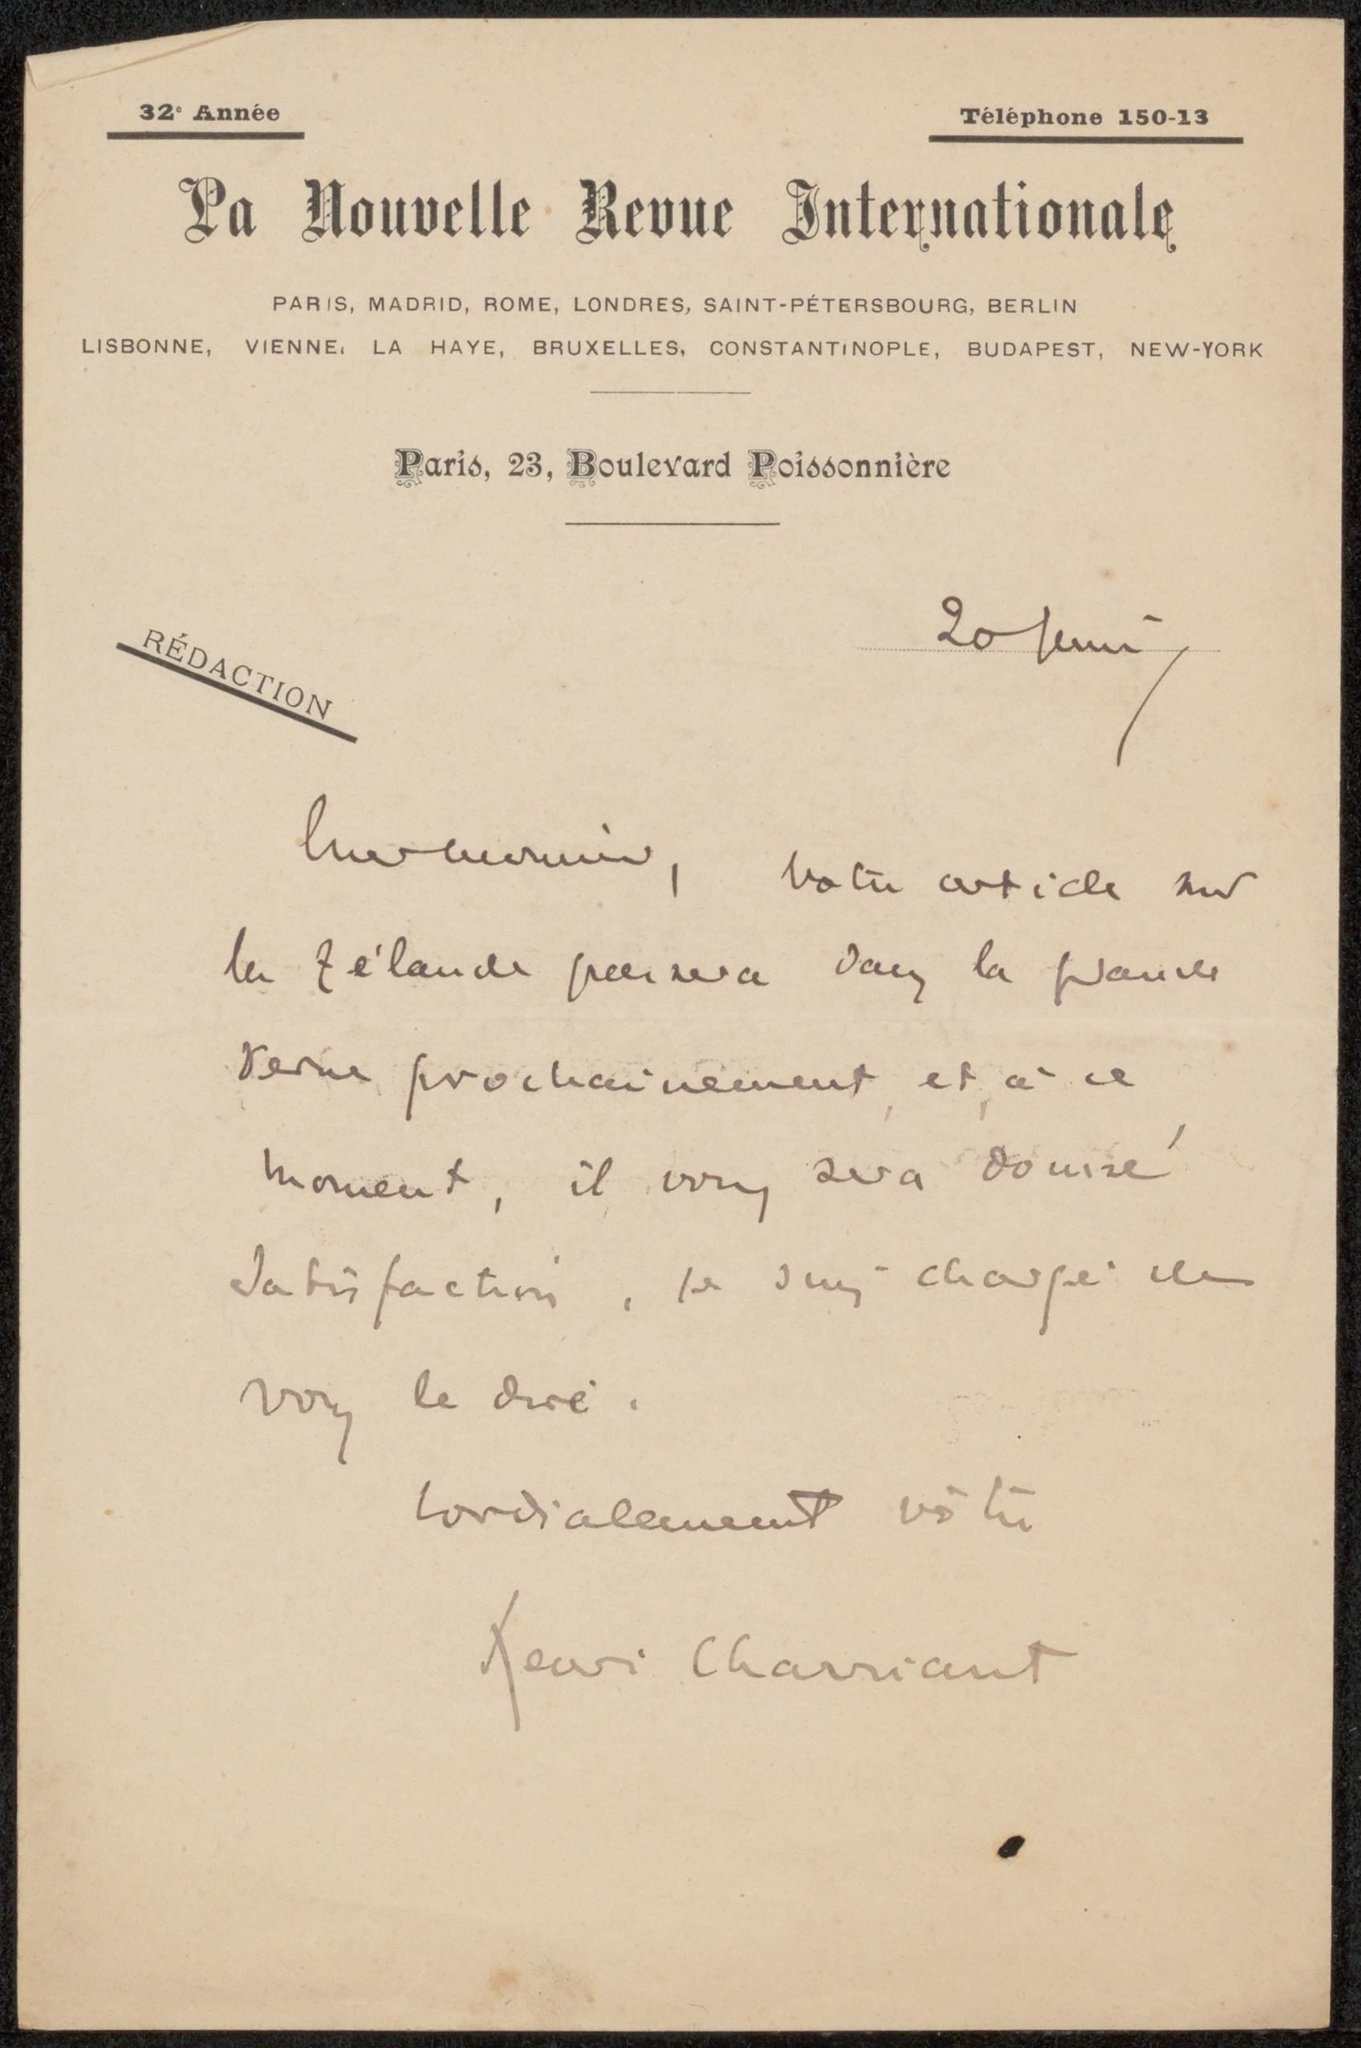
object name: letter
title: Brief aan Philip Zilcken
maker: henri charriant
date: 1867-1930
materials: ink, paper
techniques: pen, printing, writing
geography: paris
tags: the hague, painter, draughtsman, philip zilcken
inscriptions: collector's mark: ‘RPK’